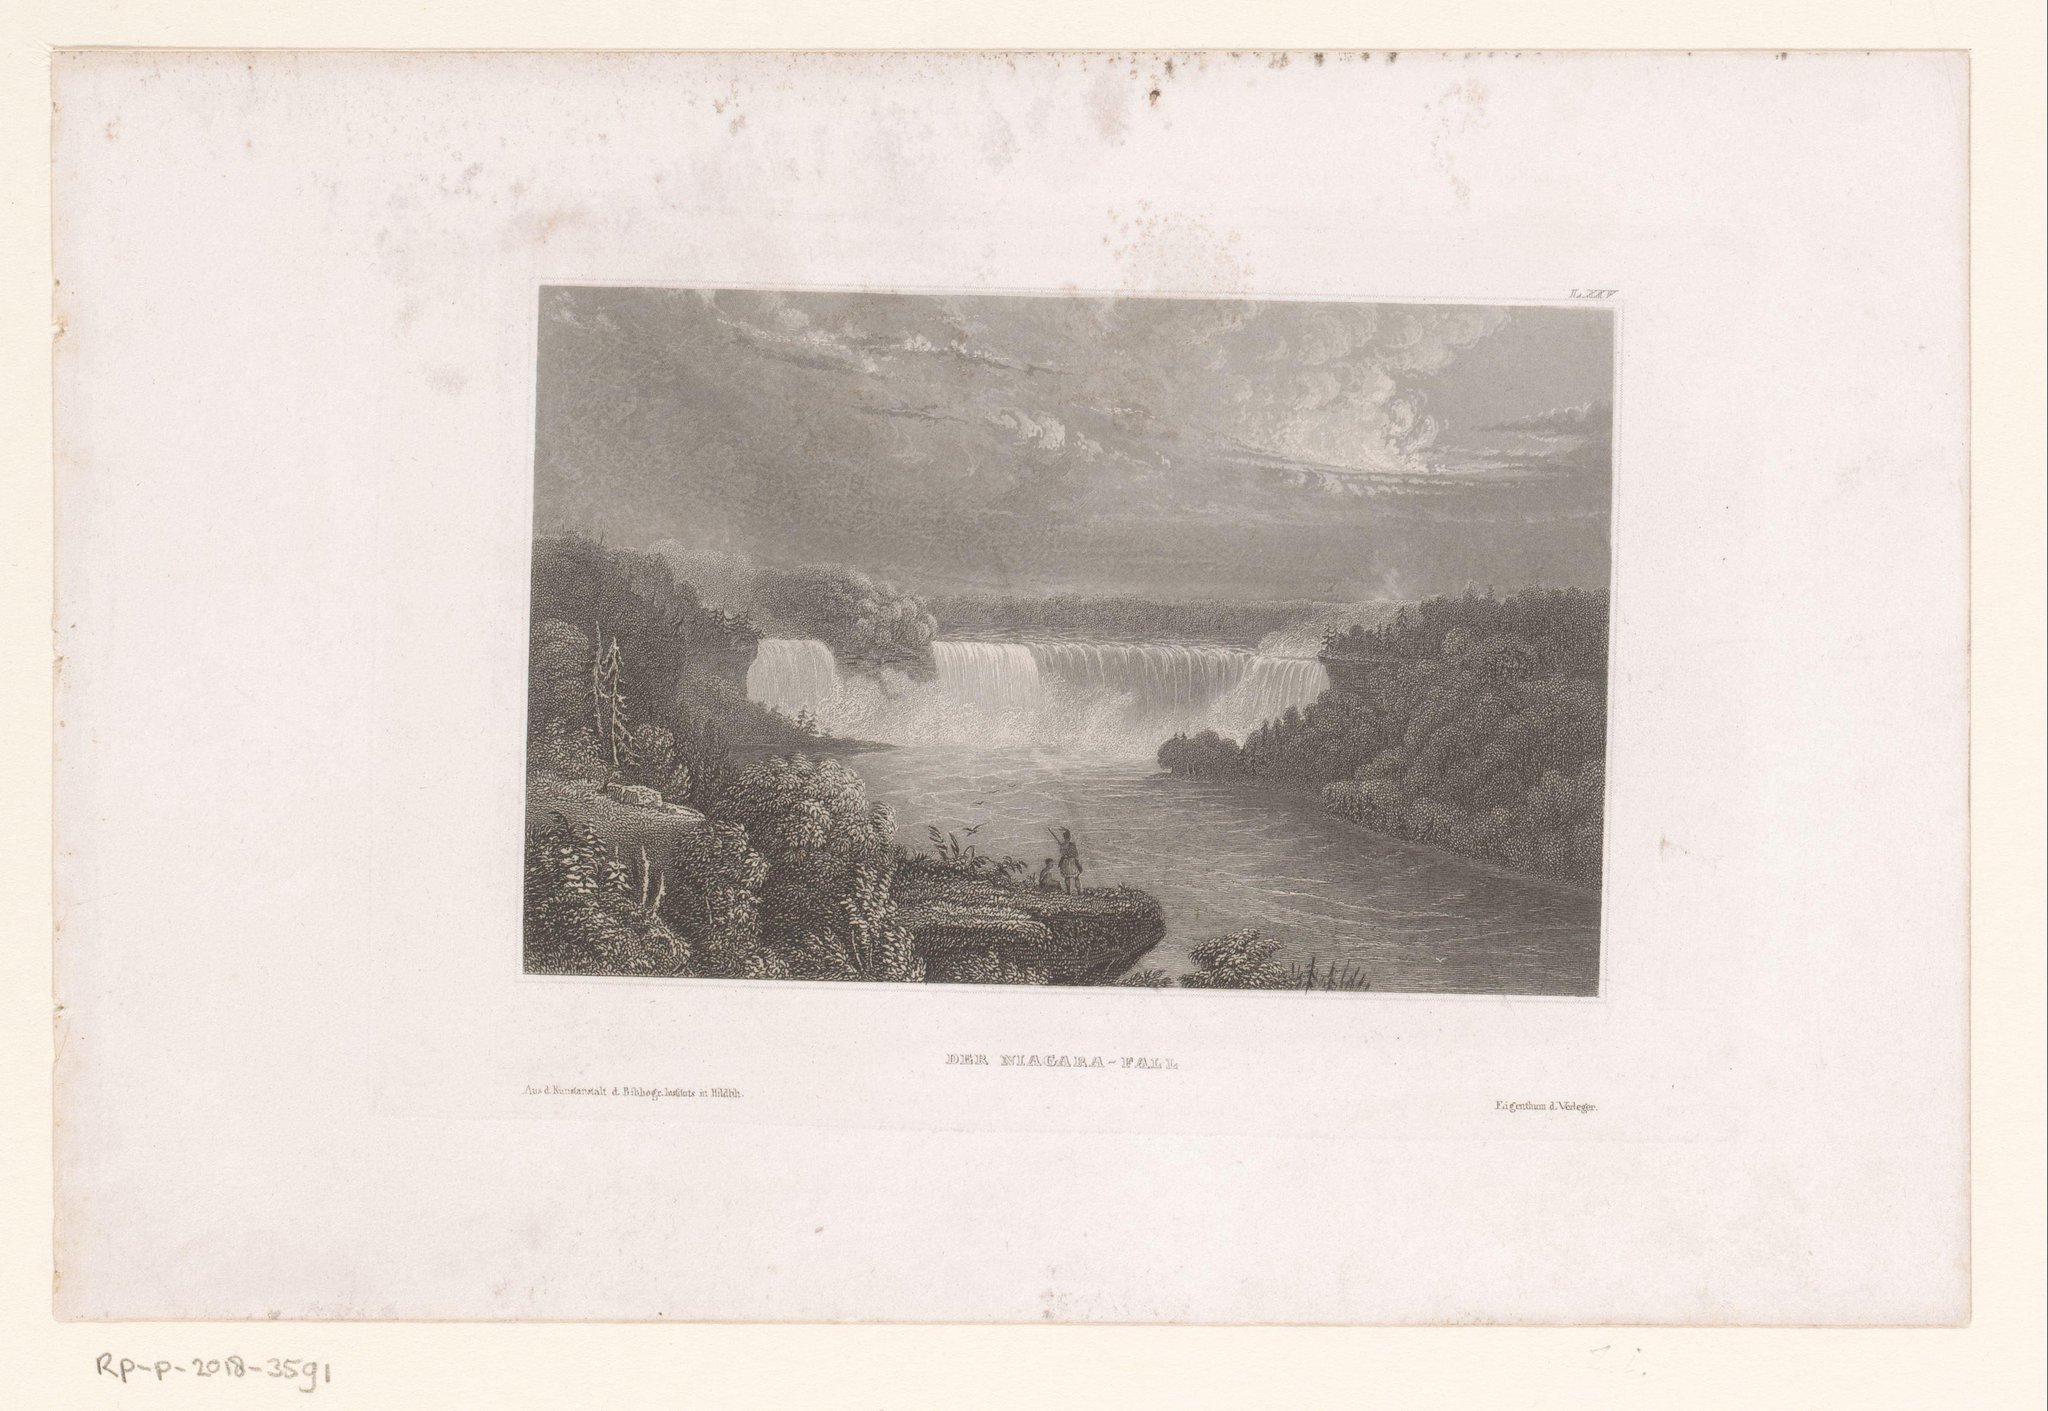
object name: print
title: Niagarawatervallen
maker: Anonymous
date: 1835-1863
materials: paper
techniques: engraving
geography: hildburghausen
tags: waterfall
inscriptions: collector's mark: Lugt 2228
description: Prent verschenen in: Meyer, Joseph. Meyer's Universum. Hildburghausen: Bibliographisches Institut, 1835-1863.